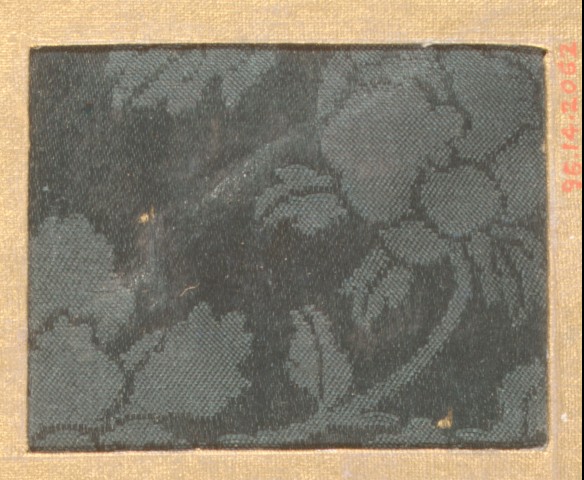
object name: piece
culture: japanese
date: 1701-1900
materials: silk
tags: flowers